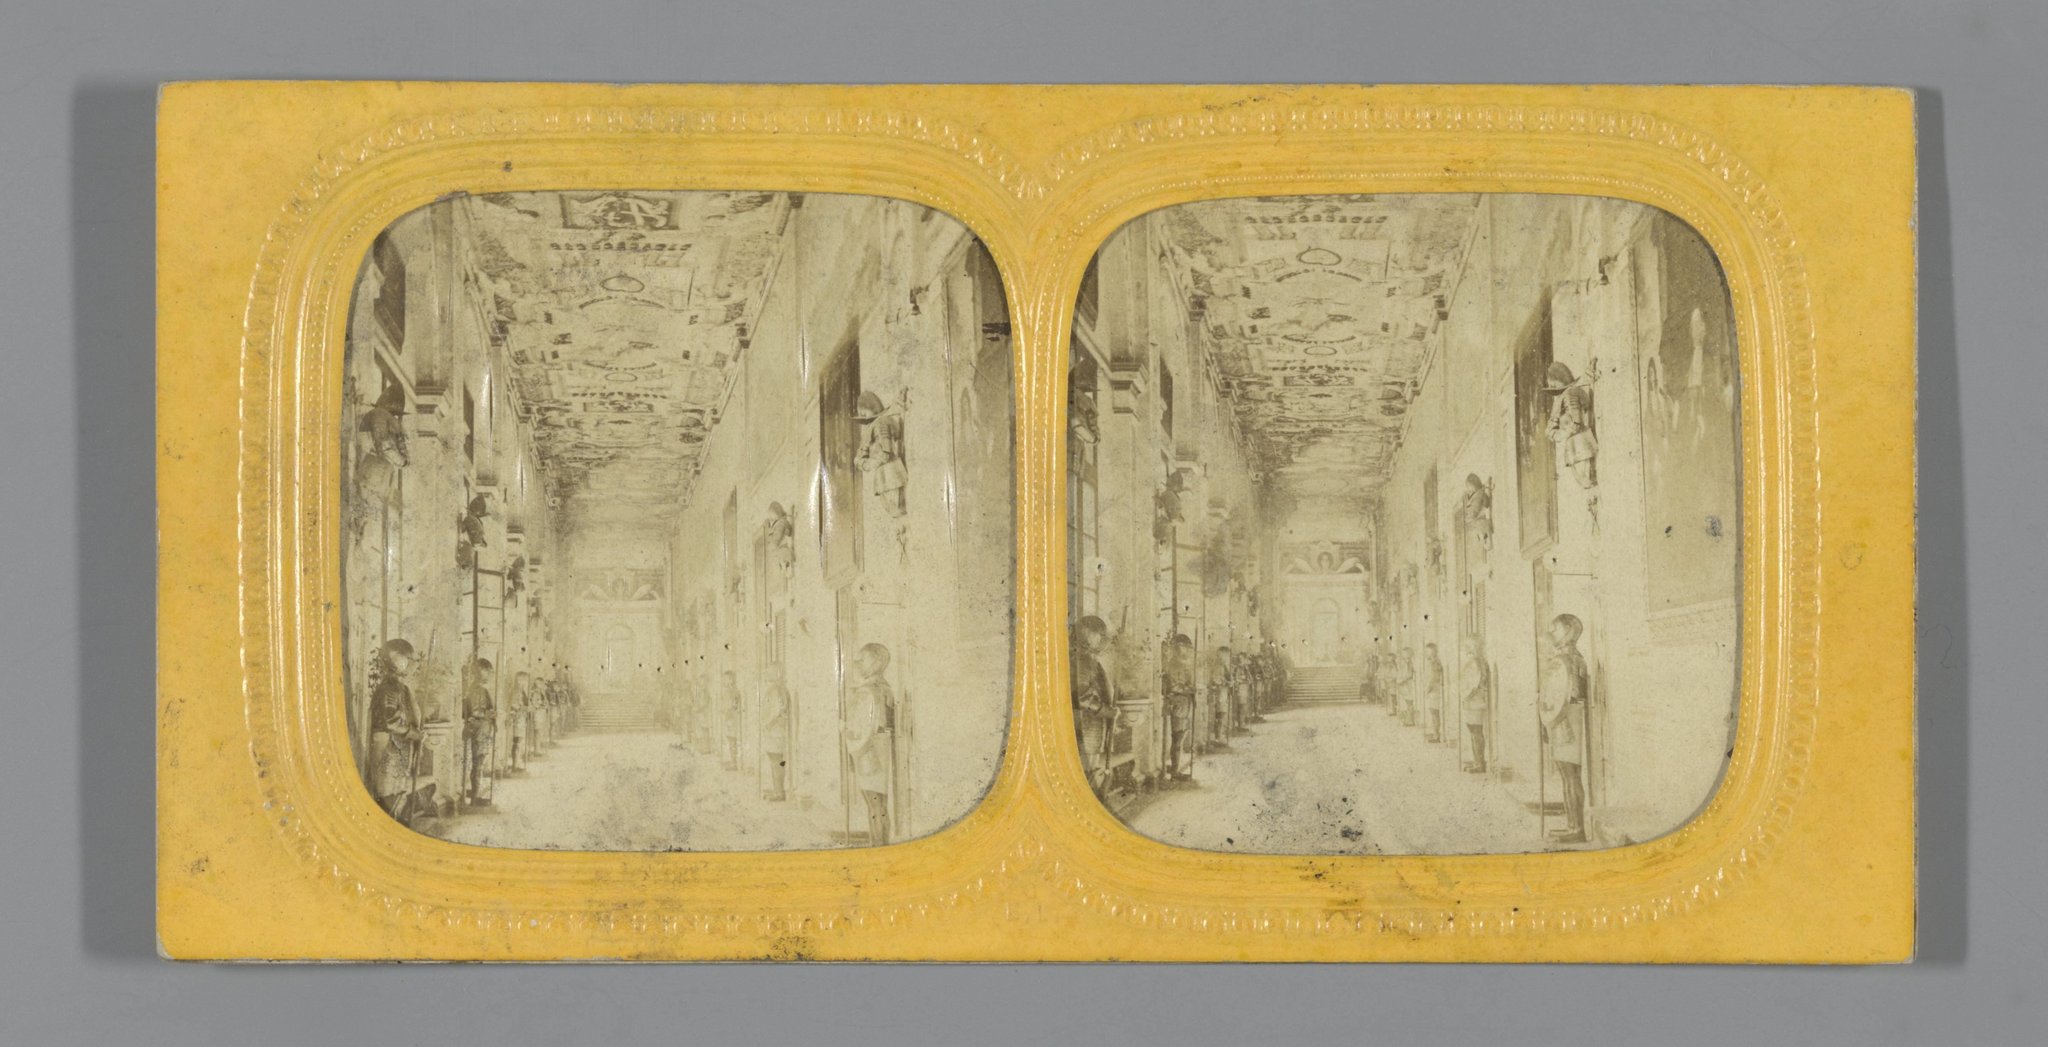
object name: tissue stereograph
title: Gang met harnassen in het Grootmeesterspaleis in Valletta, Malta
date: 1855-1875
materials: cardboard, paper, photographic support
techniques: albumen print, cutting, hand coloring, perforating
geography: valletta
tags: armour, gallery (spacious corridor)